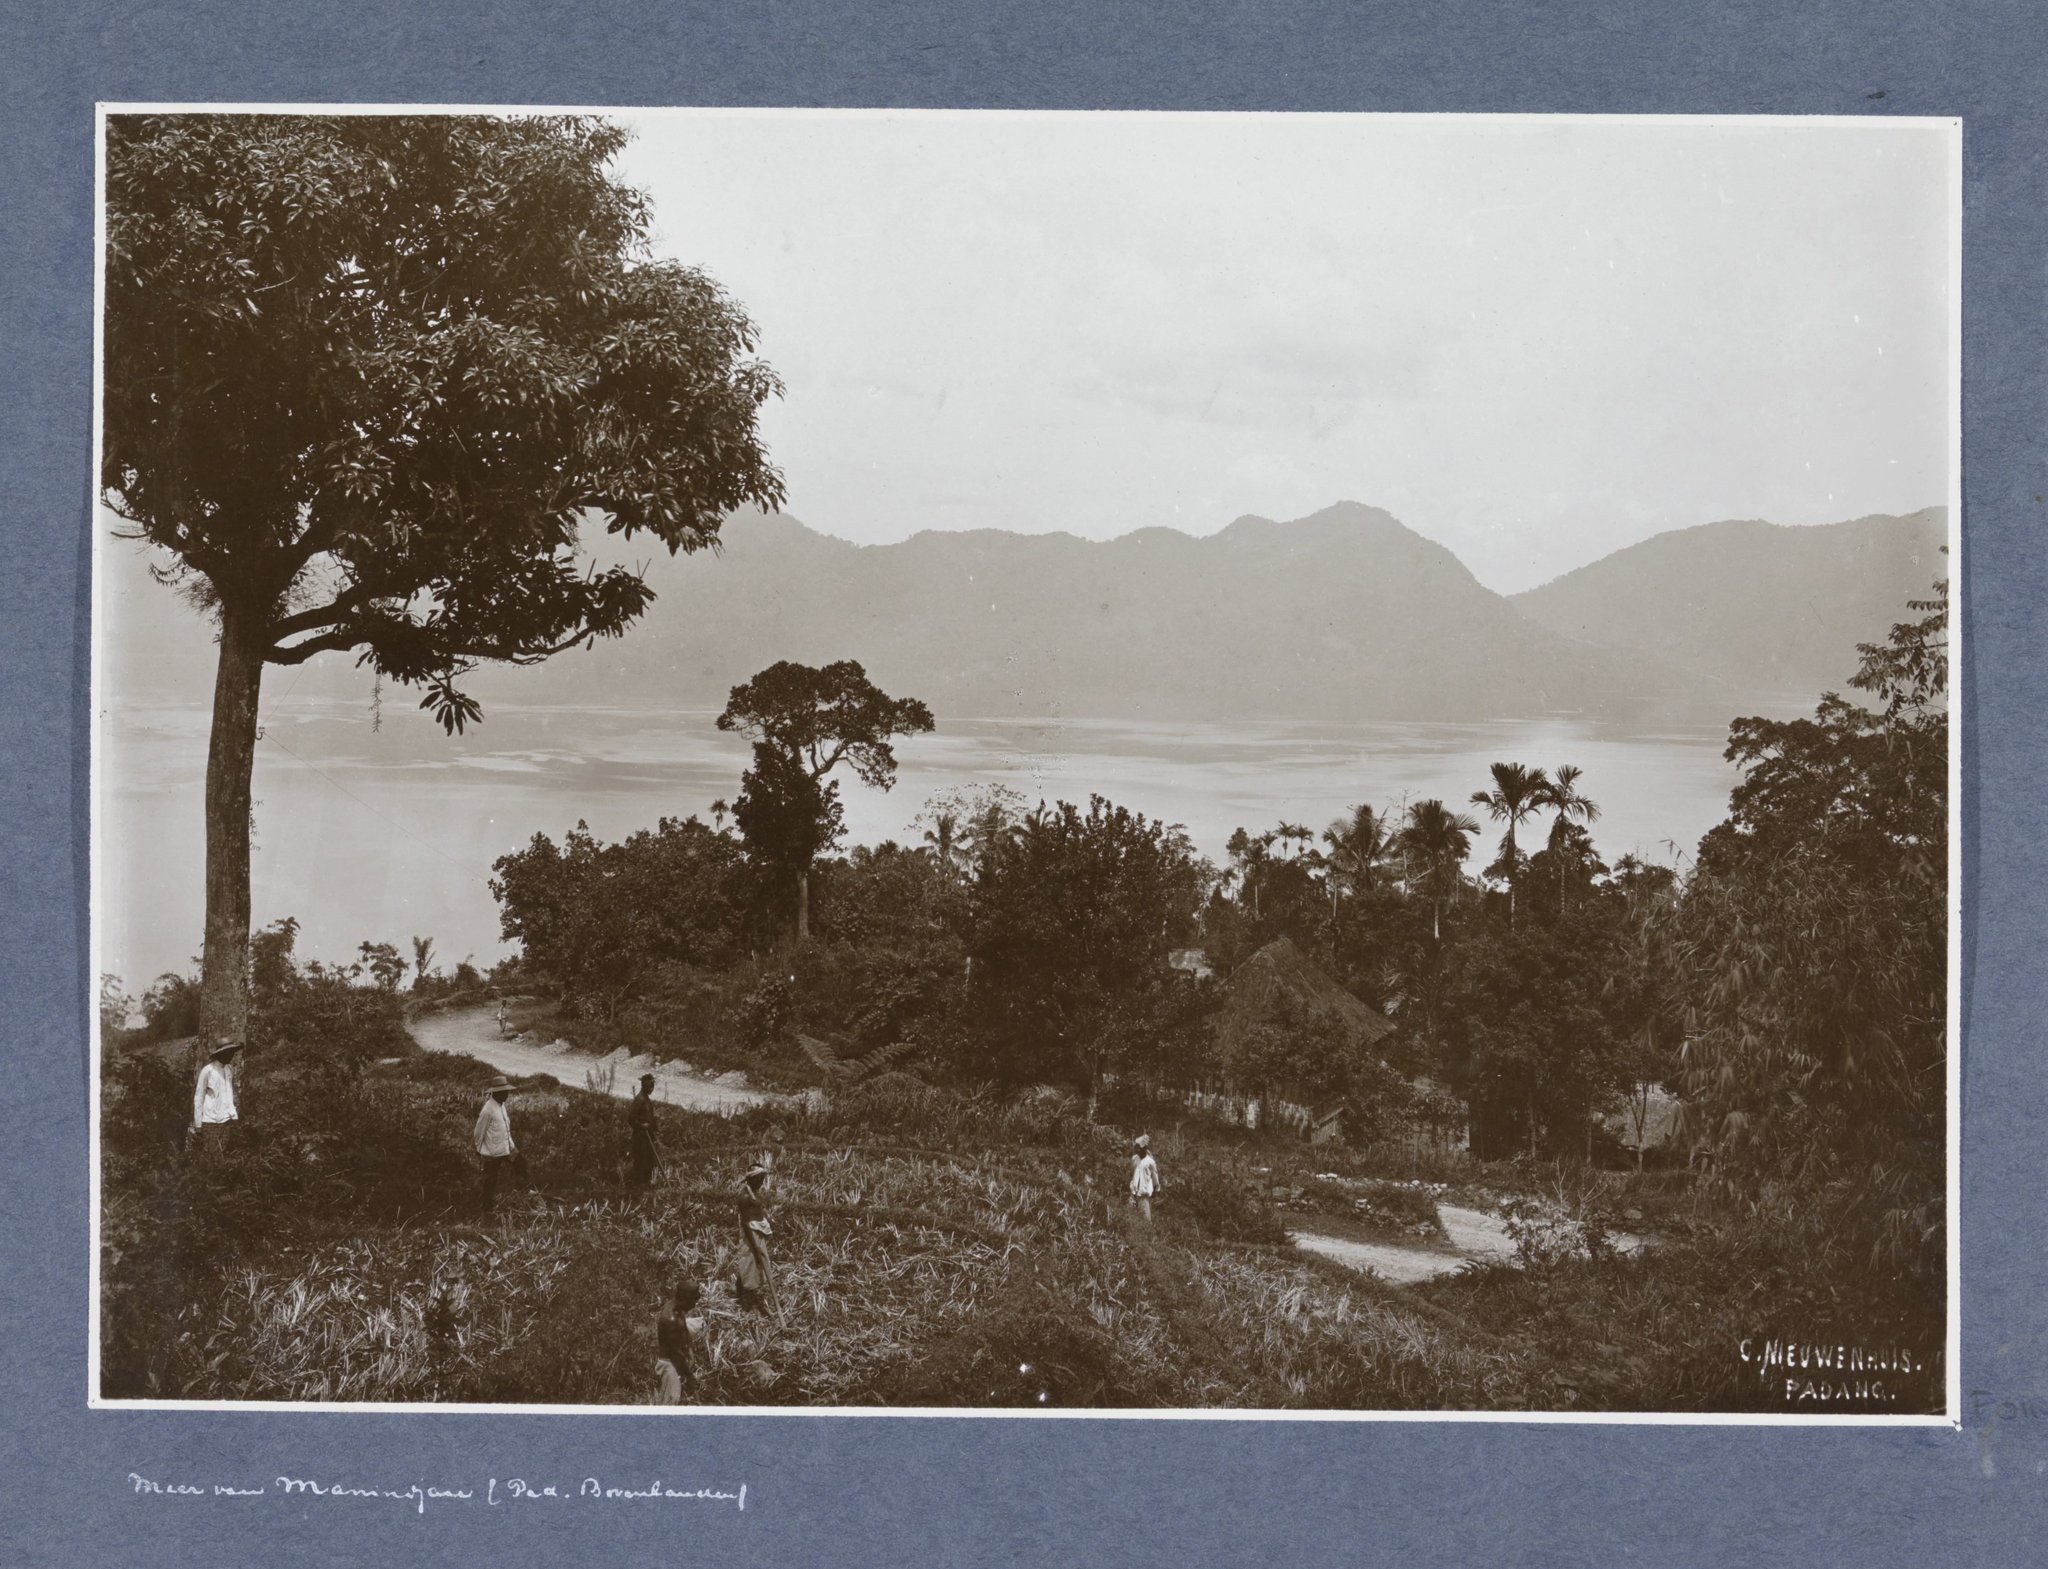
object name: album leaf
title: Gezicht op het Meer van Manindjau op Sumatra met op de voorgrond Indische landarbeiders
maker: christiaan benjamin nieuwenhuis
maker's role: publisher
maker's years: 1863-1922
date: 1900-1920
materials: paper, photographic support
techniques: gelatin silver print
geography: sumatra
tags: working class, labourers, lake, sumatra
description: Onderdeel van reisalbum met foto's van bedrijvigheid en bezienswaardigheden op Sumatra en Java en van de reis naar en van Nederlands-Indië.